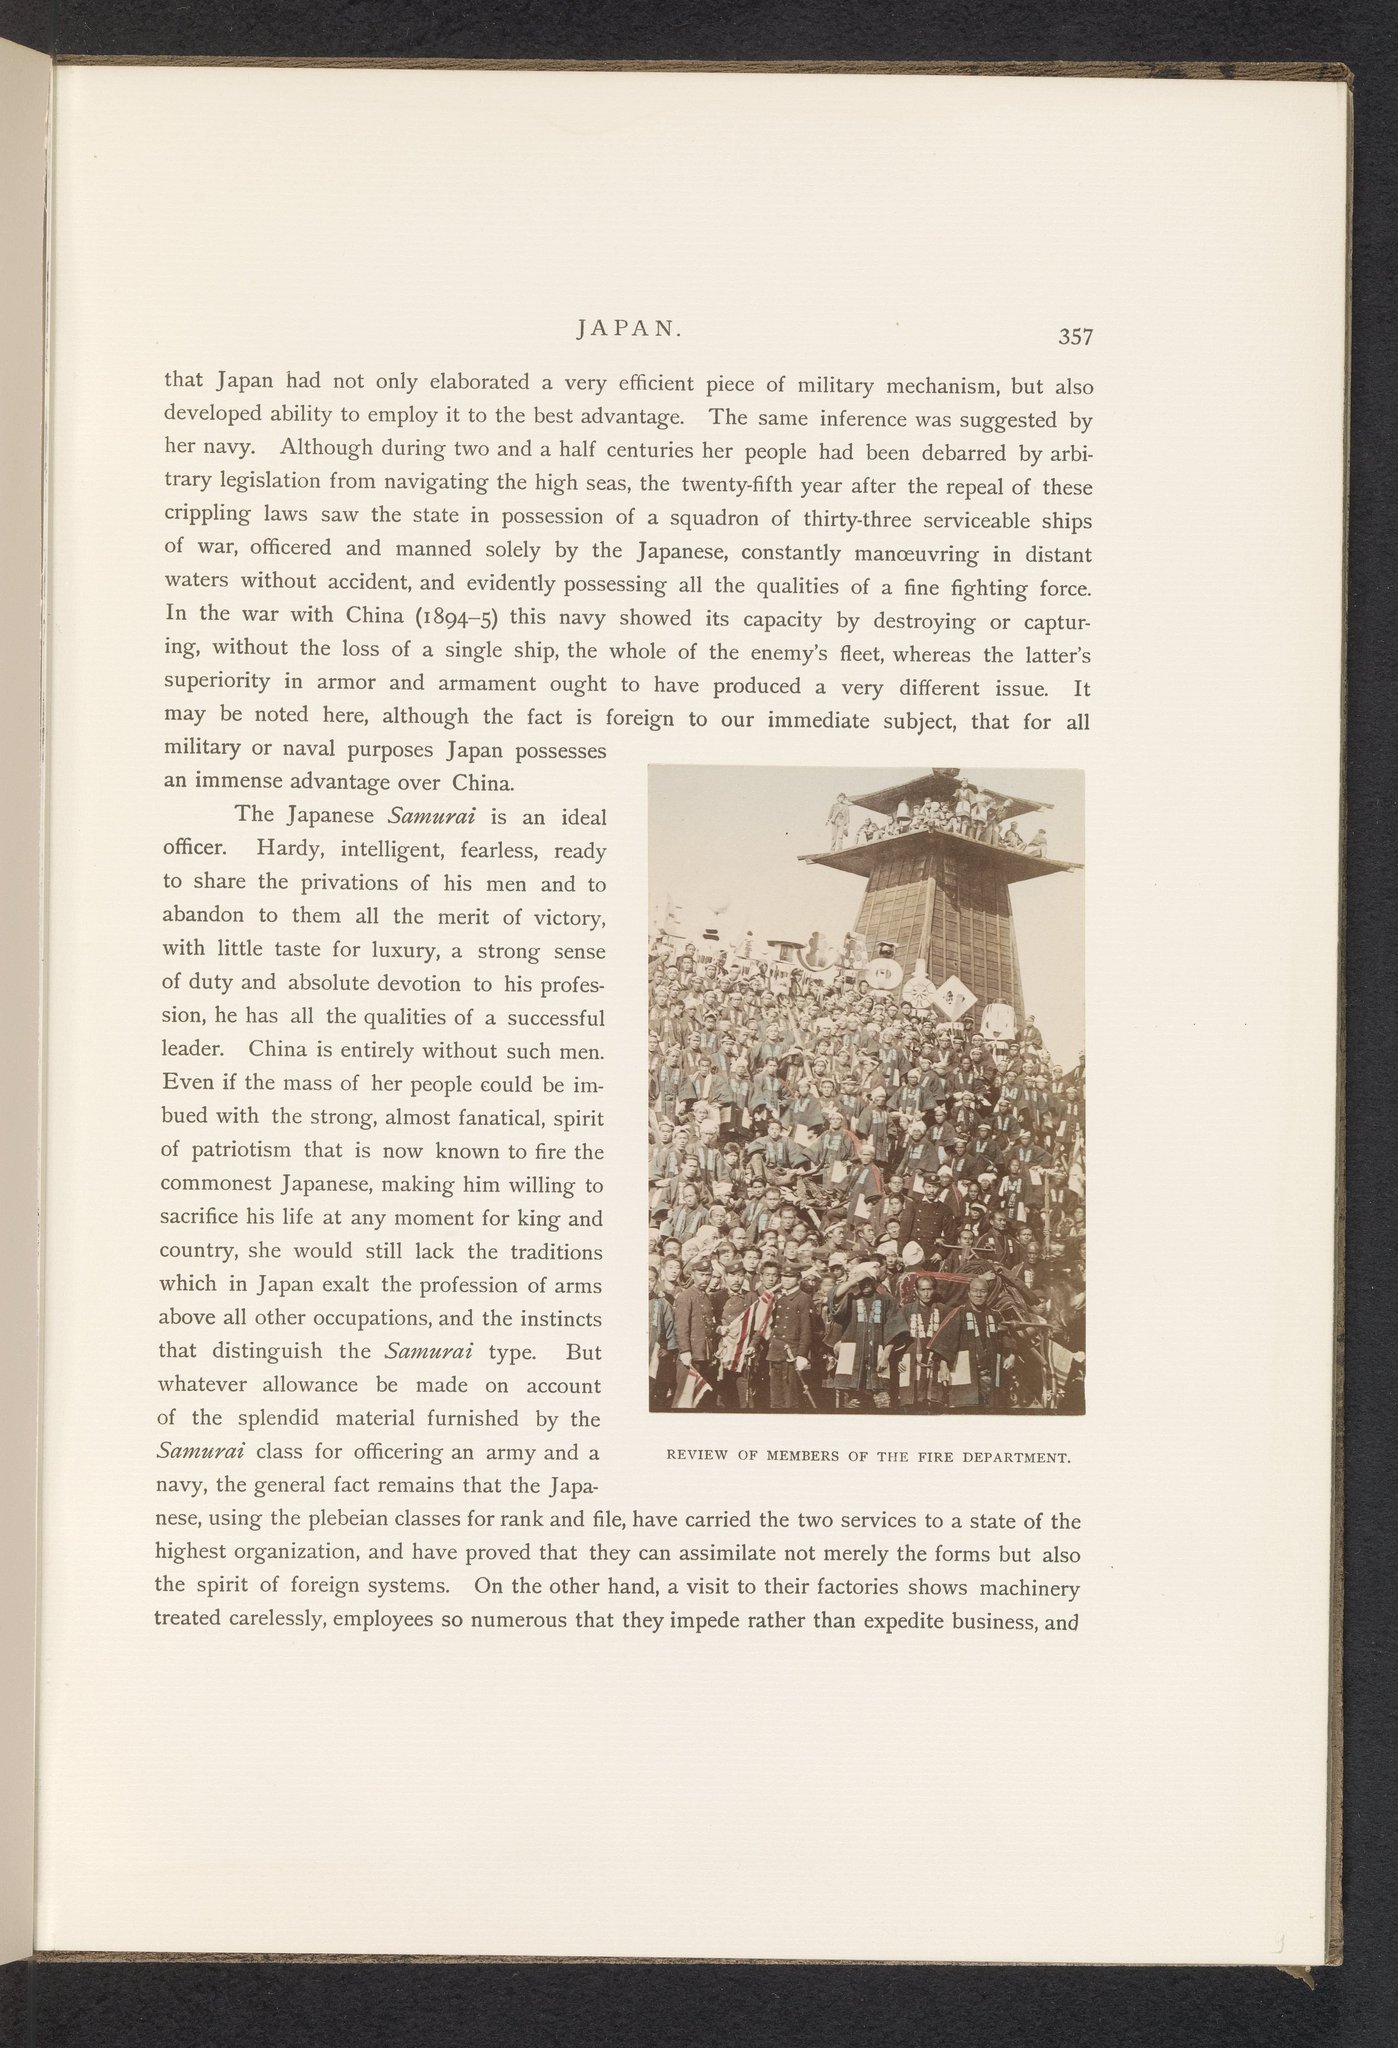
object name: photograph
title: Review of members of the fire department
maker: Anonymous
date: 1888-1898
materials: photographic support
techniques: albumen print, hand coloring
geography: japan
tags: fire-department, fire-brigade, firemen